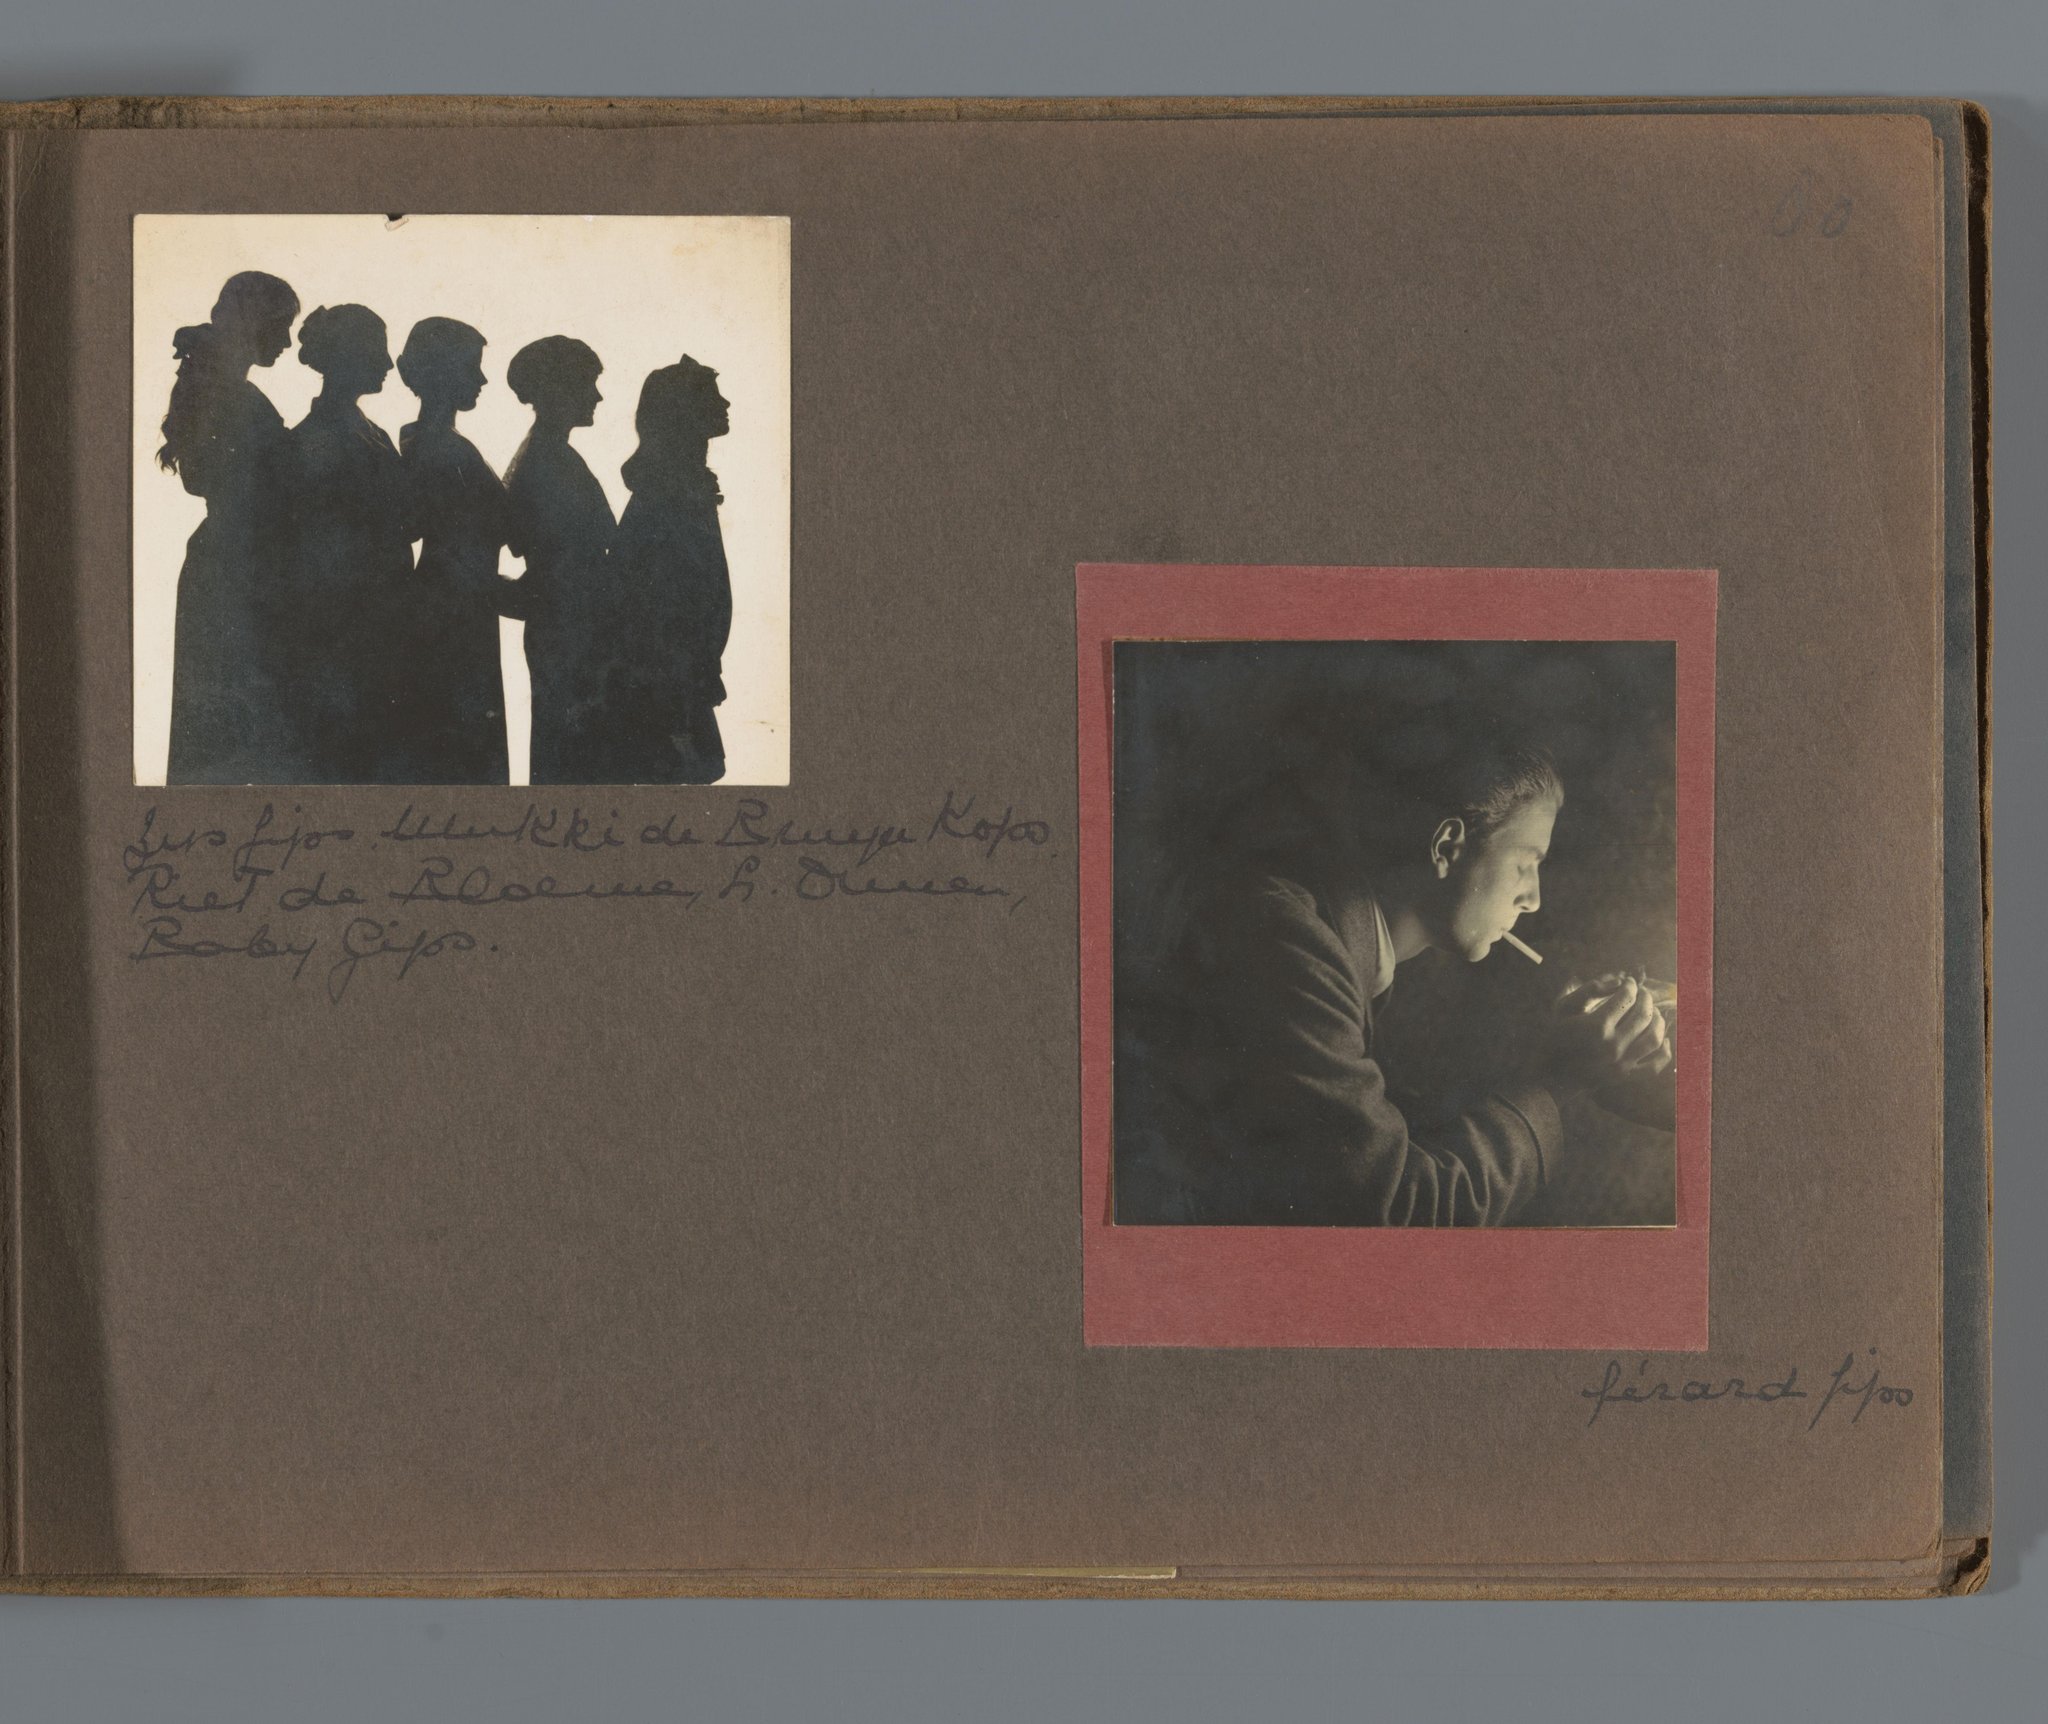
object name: album leaf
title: Silhouetfoto van een groep mensen, waaronder Loentje Onnen, en een portret van Gérard Gips met sigaret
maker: carolina frederika onnen (lien/loen)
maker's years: 1896-1983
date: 1914-1915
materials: paper, cardboard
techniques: gelatin silver print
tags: amsterdam, carolina frederika onnen (lien/loen), cigarette, shadow-play, historical persons, anonymous historical persons portrayed in a group, in a group-portrait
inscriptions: inscription: ‘Zus Sjors, Nikkie [?] de Bruyn Kops/ Riet de Boemen [?]/ L. Onnen,/ Baby Gips.’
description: Deze foto's zijn onderdeel van een album.